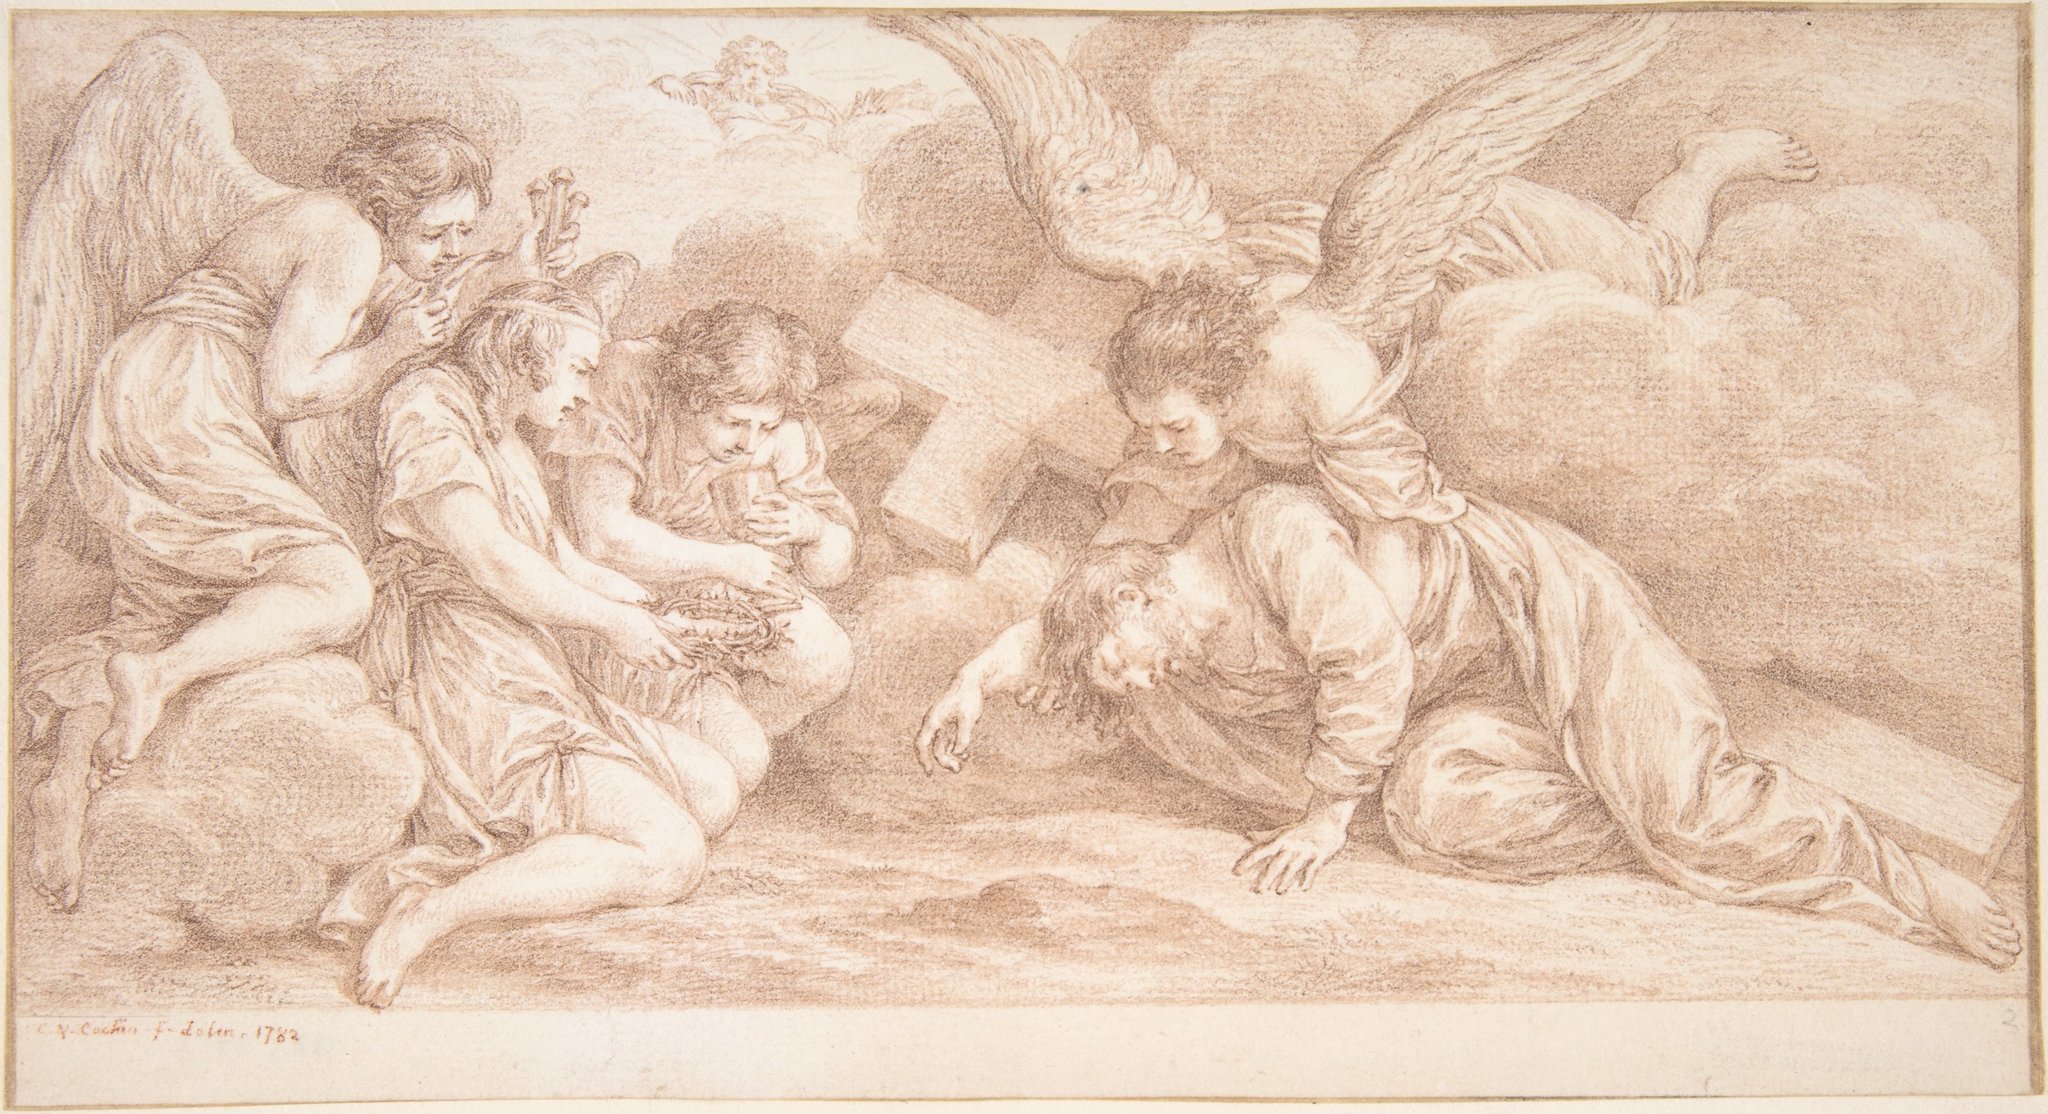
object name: drawing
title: Christ Falling under the Cross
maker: charles nicolas cochin ii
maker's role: artist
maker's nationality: french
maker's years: 1715-1790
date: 1782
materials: chalk, ink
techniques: pen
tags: angels,christ,cross